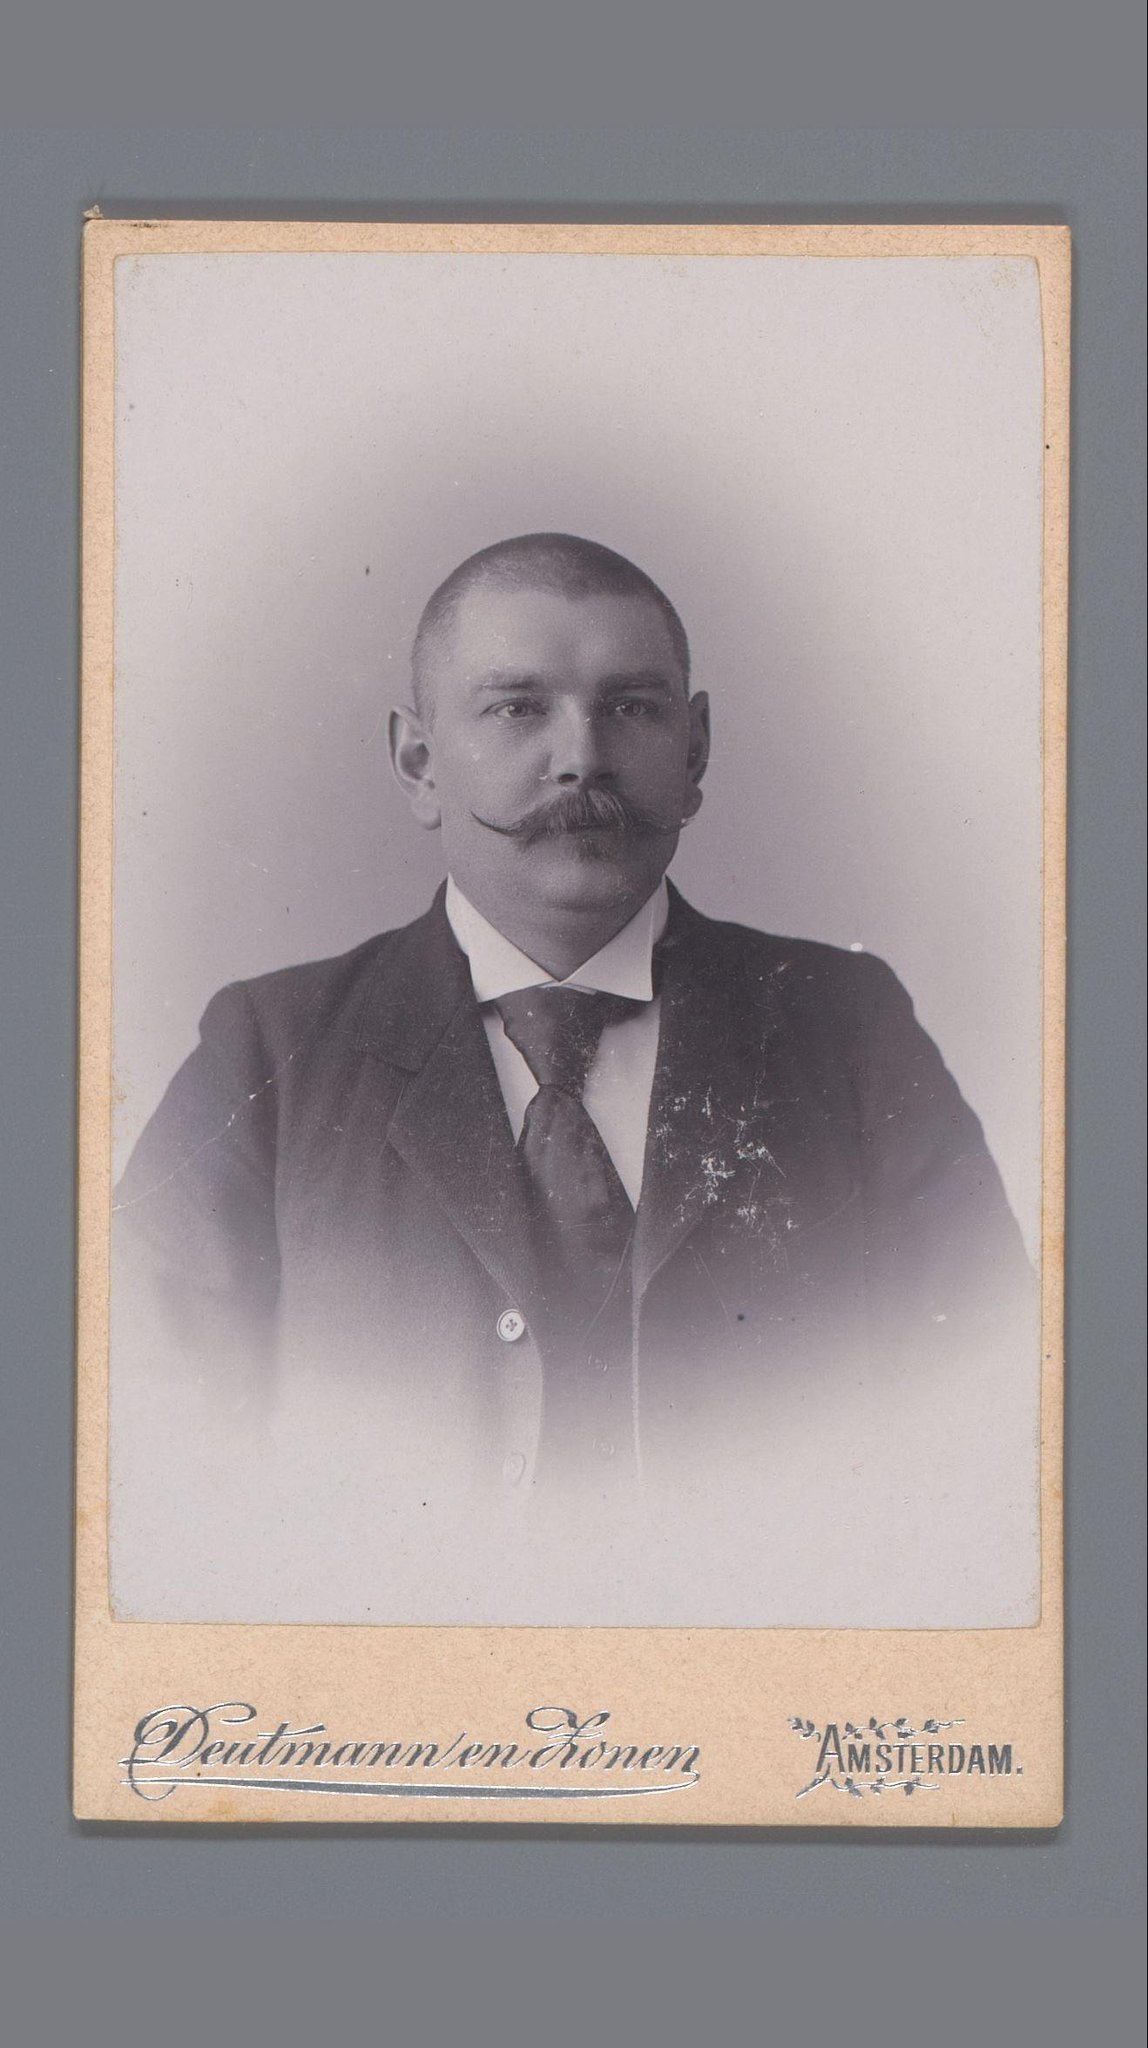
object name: photograph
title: Portret van een onbekende man met snor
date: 1803-1897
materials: paper, cardboard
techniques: collodion silver print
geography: amsterdam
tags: adult man, anonymous historical person portrayed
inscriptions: inscription: ‘[...] Jan/ in opdracht [...]/ zijn [...]’, address: ‘AMSTERDAM/ Keizersgracht 455. Hoek Leidschestraat/ boven de Gruyer's Stores./ Entree/ Keizersgracht/ Opgang/ Per Lift.’